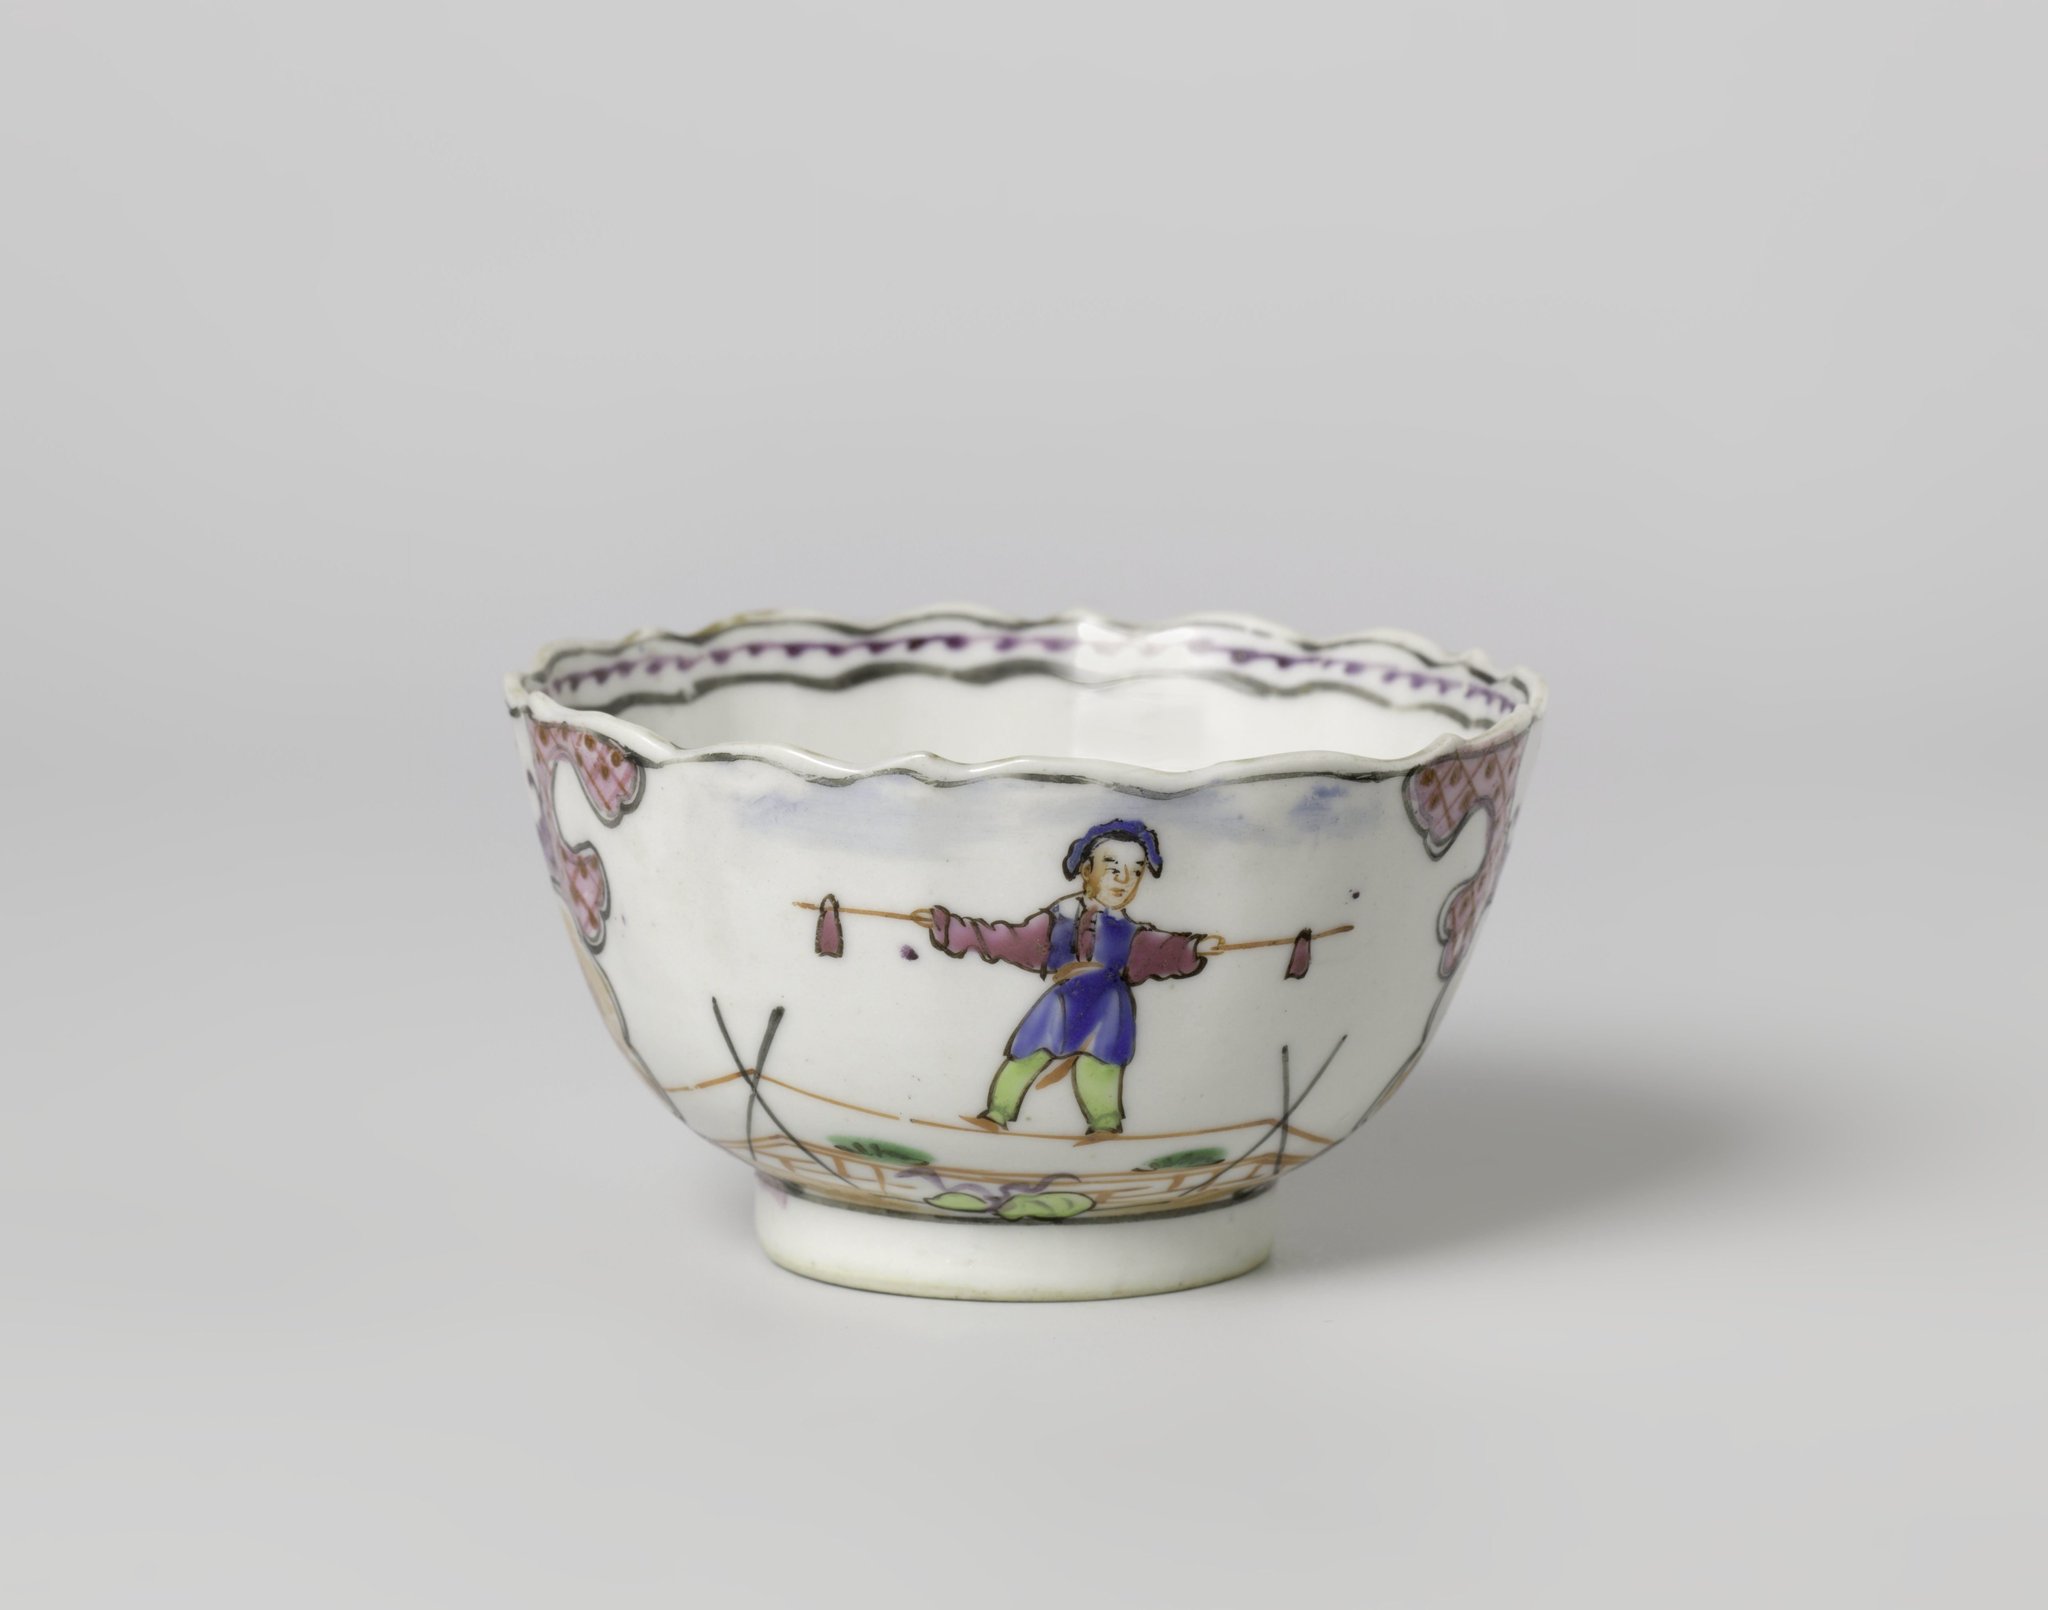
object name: cup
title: Cup with three Chinese acrobats and landscapes in panels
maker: Anonymous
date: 1775-1799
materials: glaze, gold, paint, porcelain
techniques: firing, gilding, turning, vitrification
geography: china